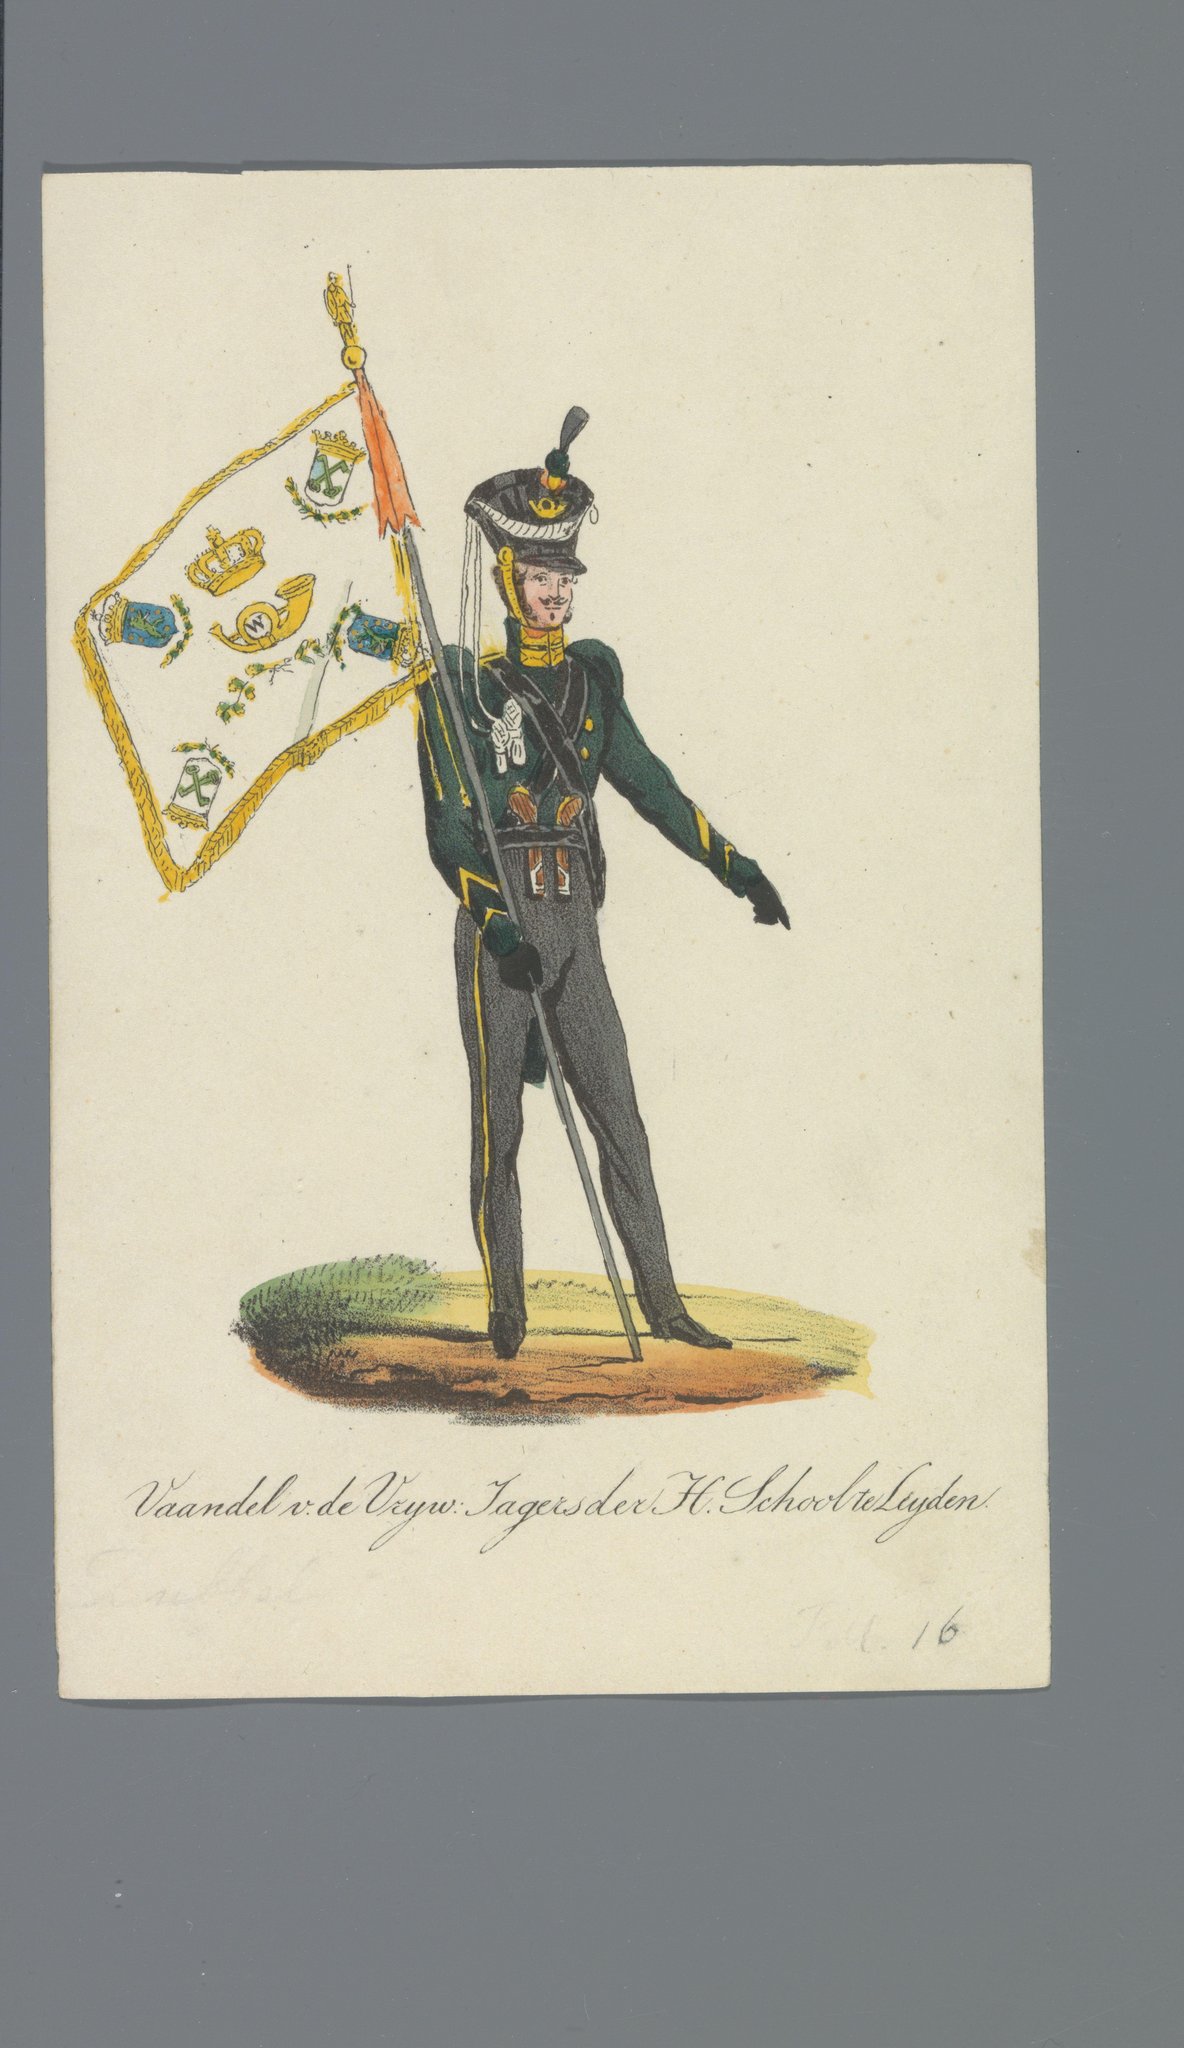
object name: print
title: Vaandel v. de Vrijw: Jagers der H. school te Leyden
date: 1835-1850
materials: paper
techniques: hand coloring, lithograph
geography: utrecht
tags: standard-bearer, flag-bearer, (military) uniforms, clothes, costume, leiden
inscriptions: collector's mark: Lugt 2227, collector's mark: Lugt 2228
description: Staande jager, vaandeldrager met het vaandel van de Compagnie Vrijwillige Jagers van de Hogeschool te Leiden. Onderdeel van een serie van 157 losse bladen met Nederlandse militaire uniformen in de jaren 1830-1832.